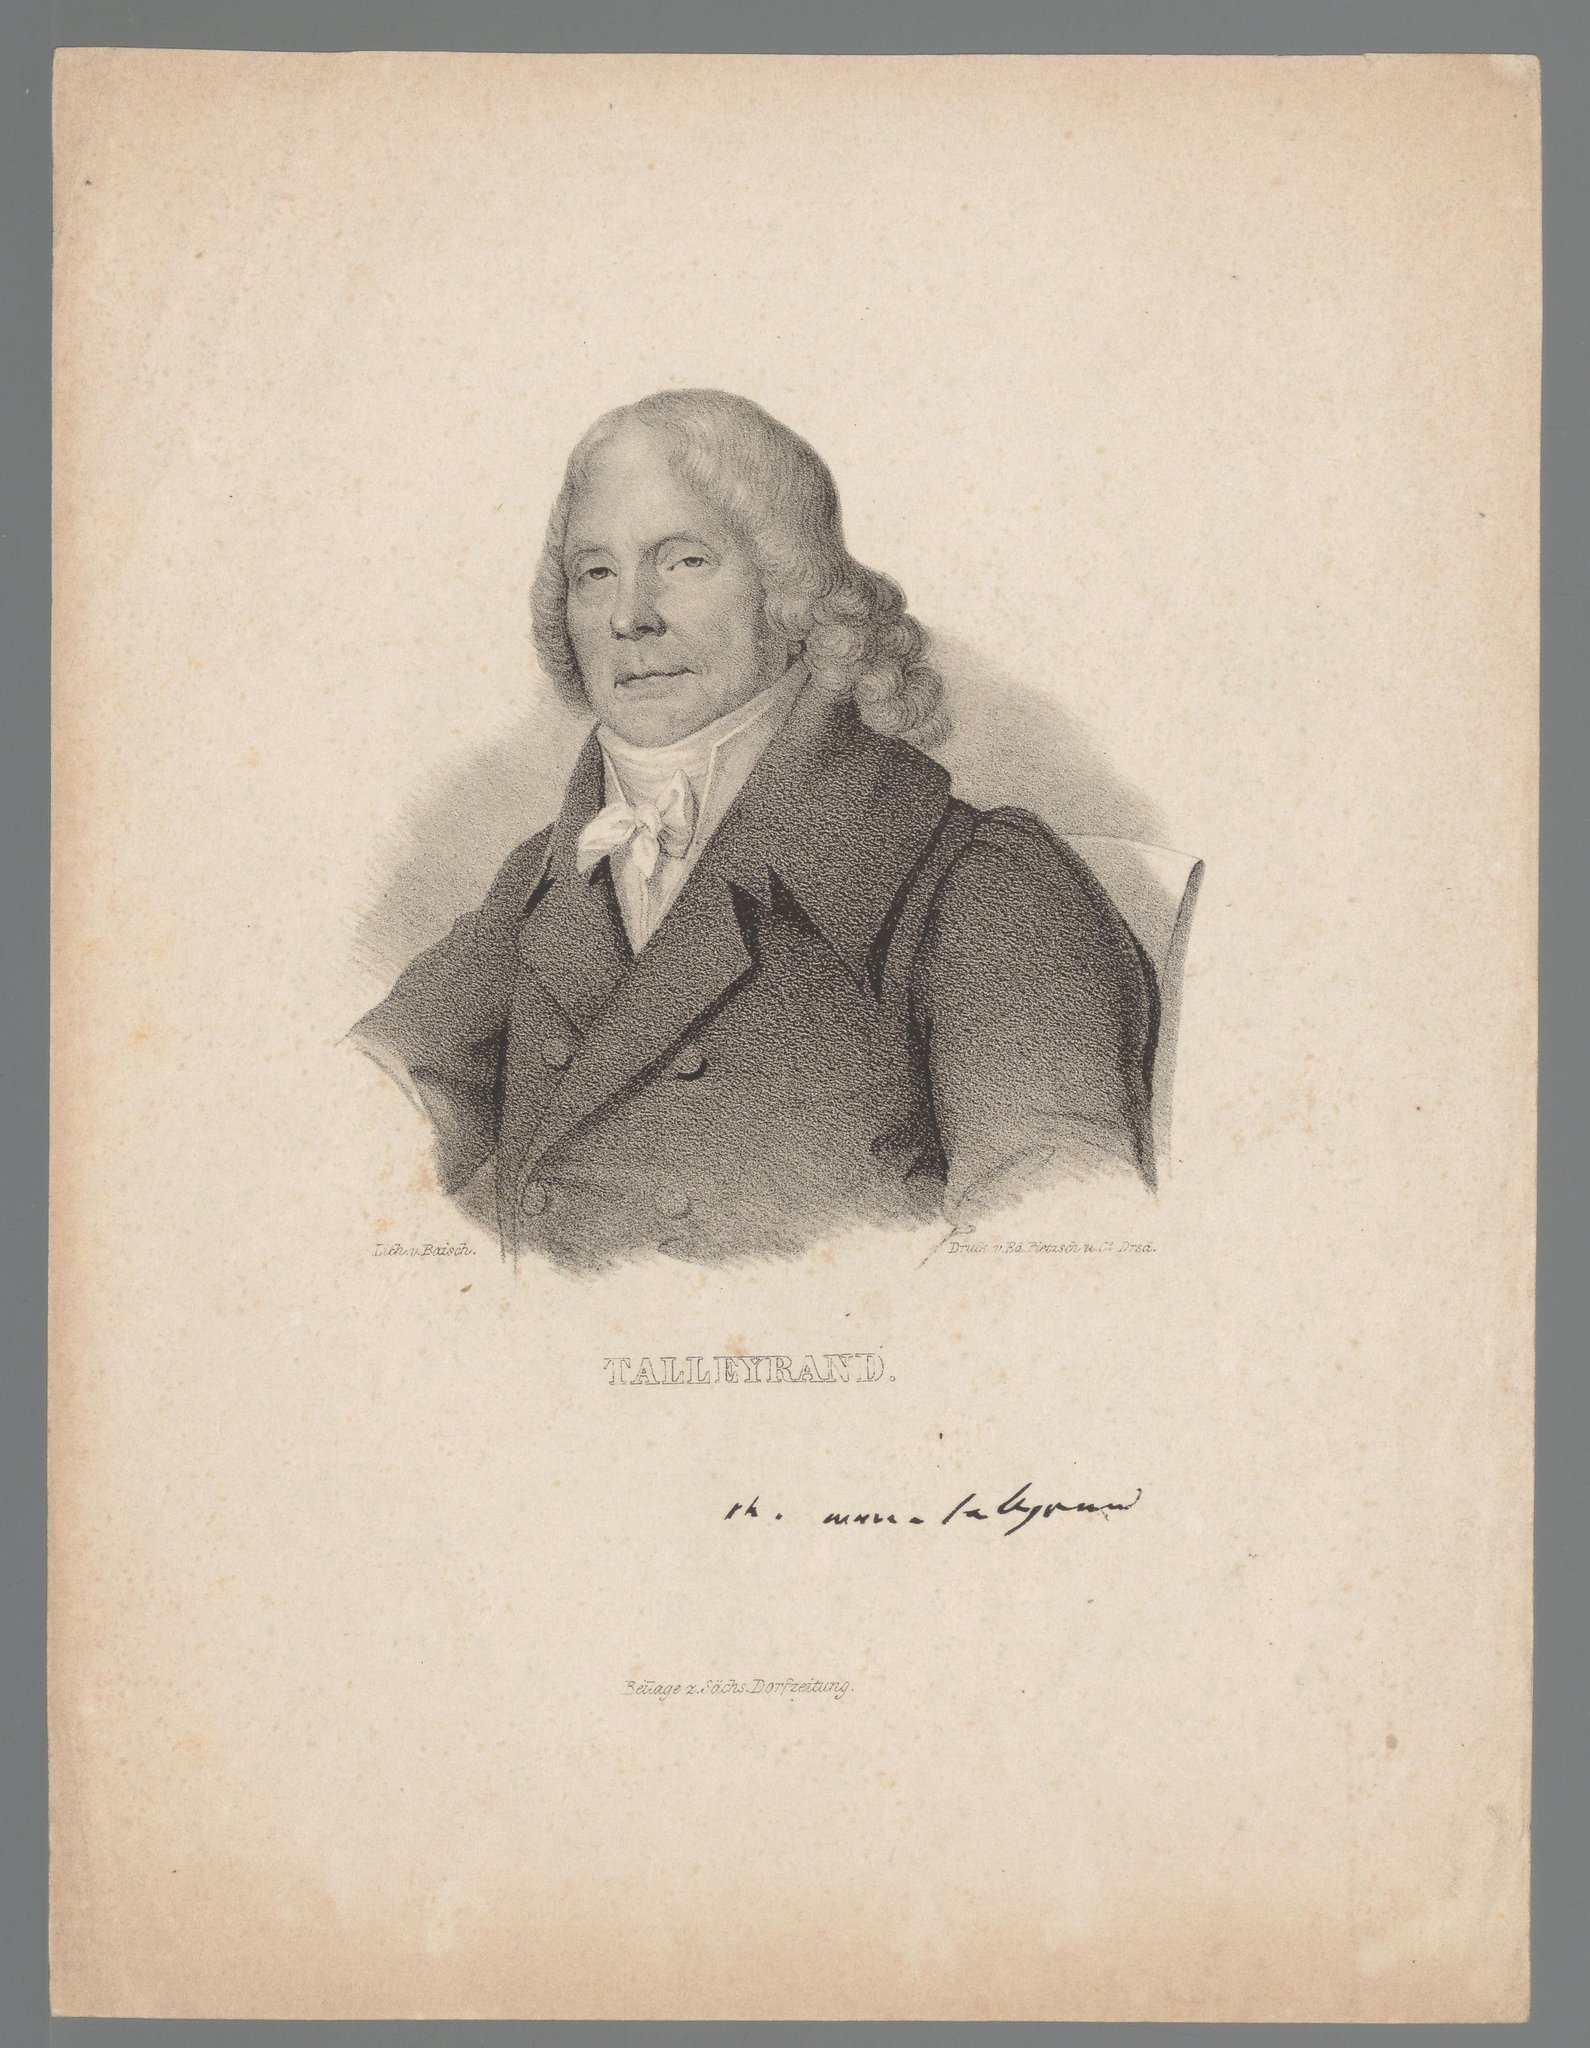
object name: print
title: Portret van Charles Maurice hertog van Talleyrand-Périgord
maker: wilhelm heinrich gottlieb baisch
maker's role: print maker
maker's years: 1805-1864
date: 1815-1864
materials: paper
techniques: lithograph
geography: dresden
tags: paris, politician, charles maurice hertog van talleyrand-périgord, historical persons, politician, e.g. party leader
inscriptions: collector's mark: Lugt 2228